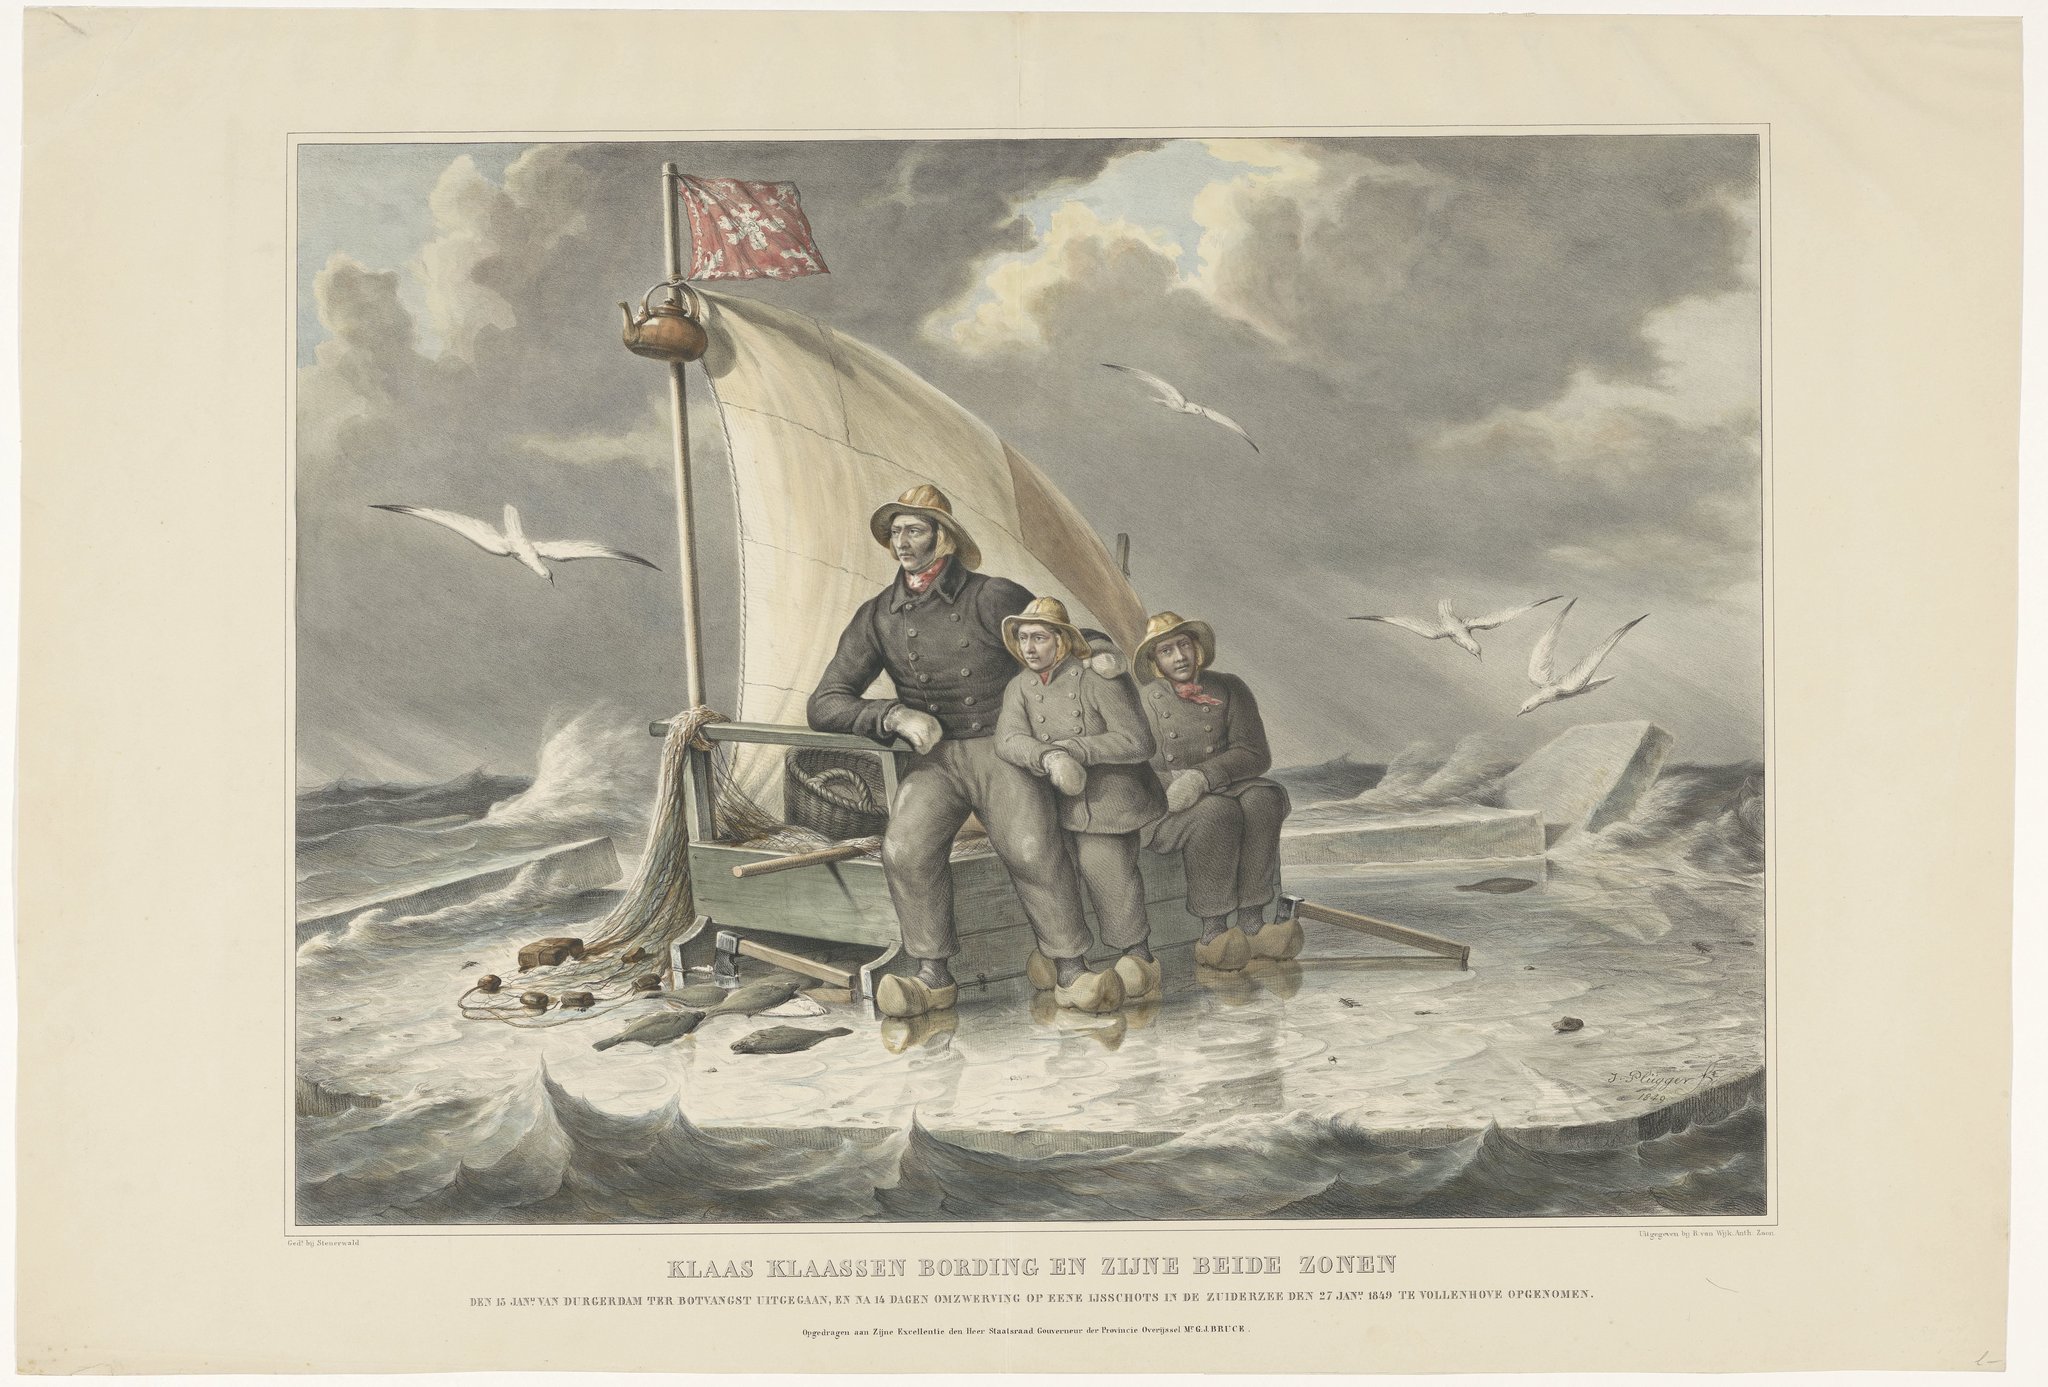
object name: print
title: Klaas Klaassen Bording en zijne beide zonen den 13 Jan.ij van Durgerdam ter botvangst uitgegaan, en na 14 dagen omzwerving op eene ijsschots in de Zuiderzee den 27 Jan,ij 1849 te Vollenhove opgenomen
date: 1849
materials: paper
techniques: hand coloring, lithograph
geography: overijssel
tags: getting lost; having lost one's way; losing one's way, sea and coastal fishery, drift ice, zuiderzee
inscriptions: collector's mark: Lugt 2228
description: Klaas Klaassen Bording en zijn twee zonen op een ijsschots veertien dagen lang op de Zuiderzee, 13-27 januari 1849. Het drietal was met een slede op het ijs gegaan om vis te vangen maar werd verrast door plotseling invallende dooi. Op 27 januari werden zij bij Vollenhove gered.